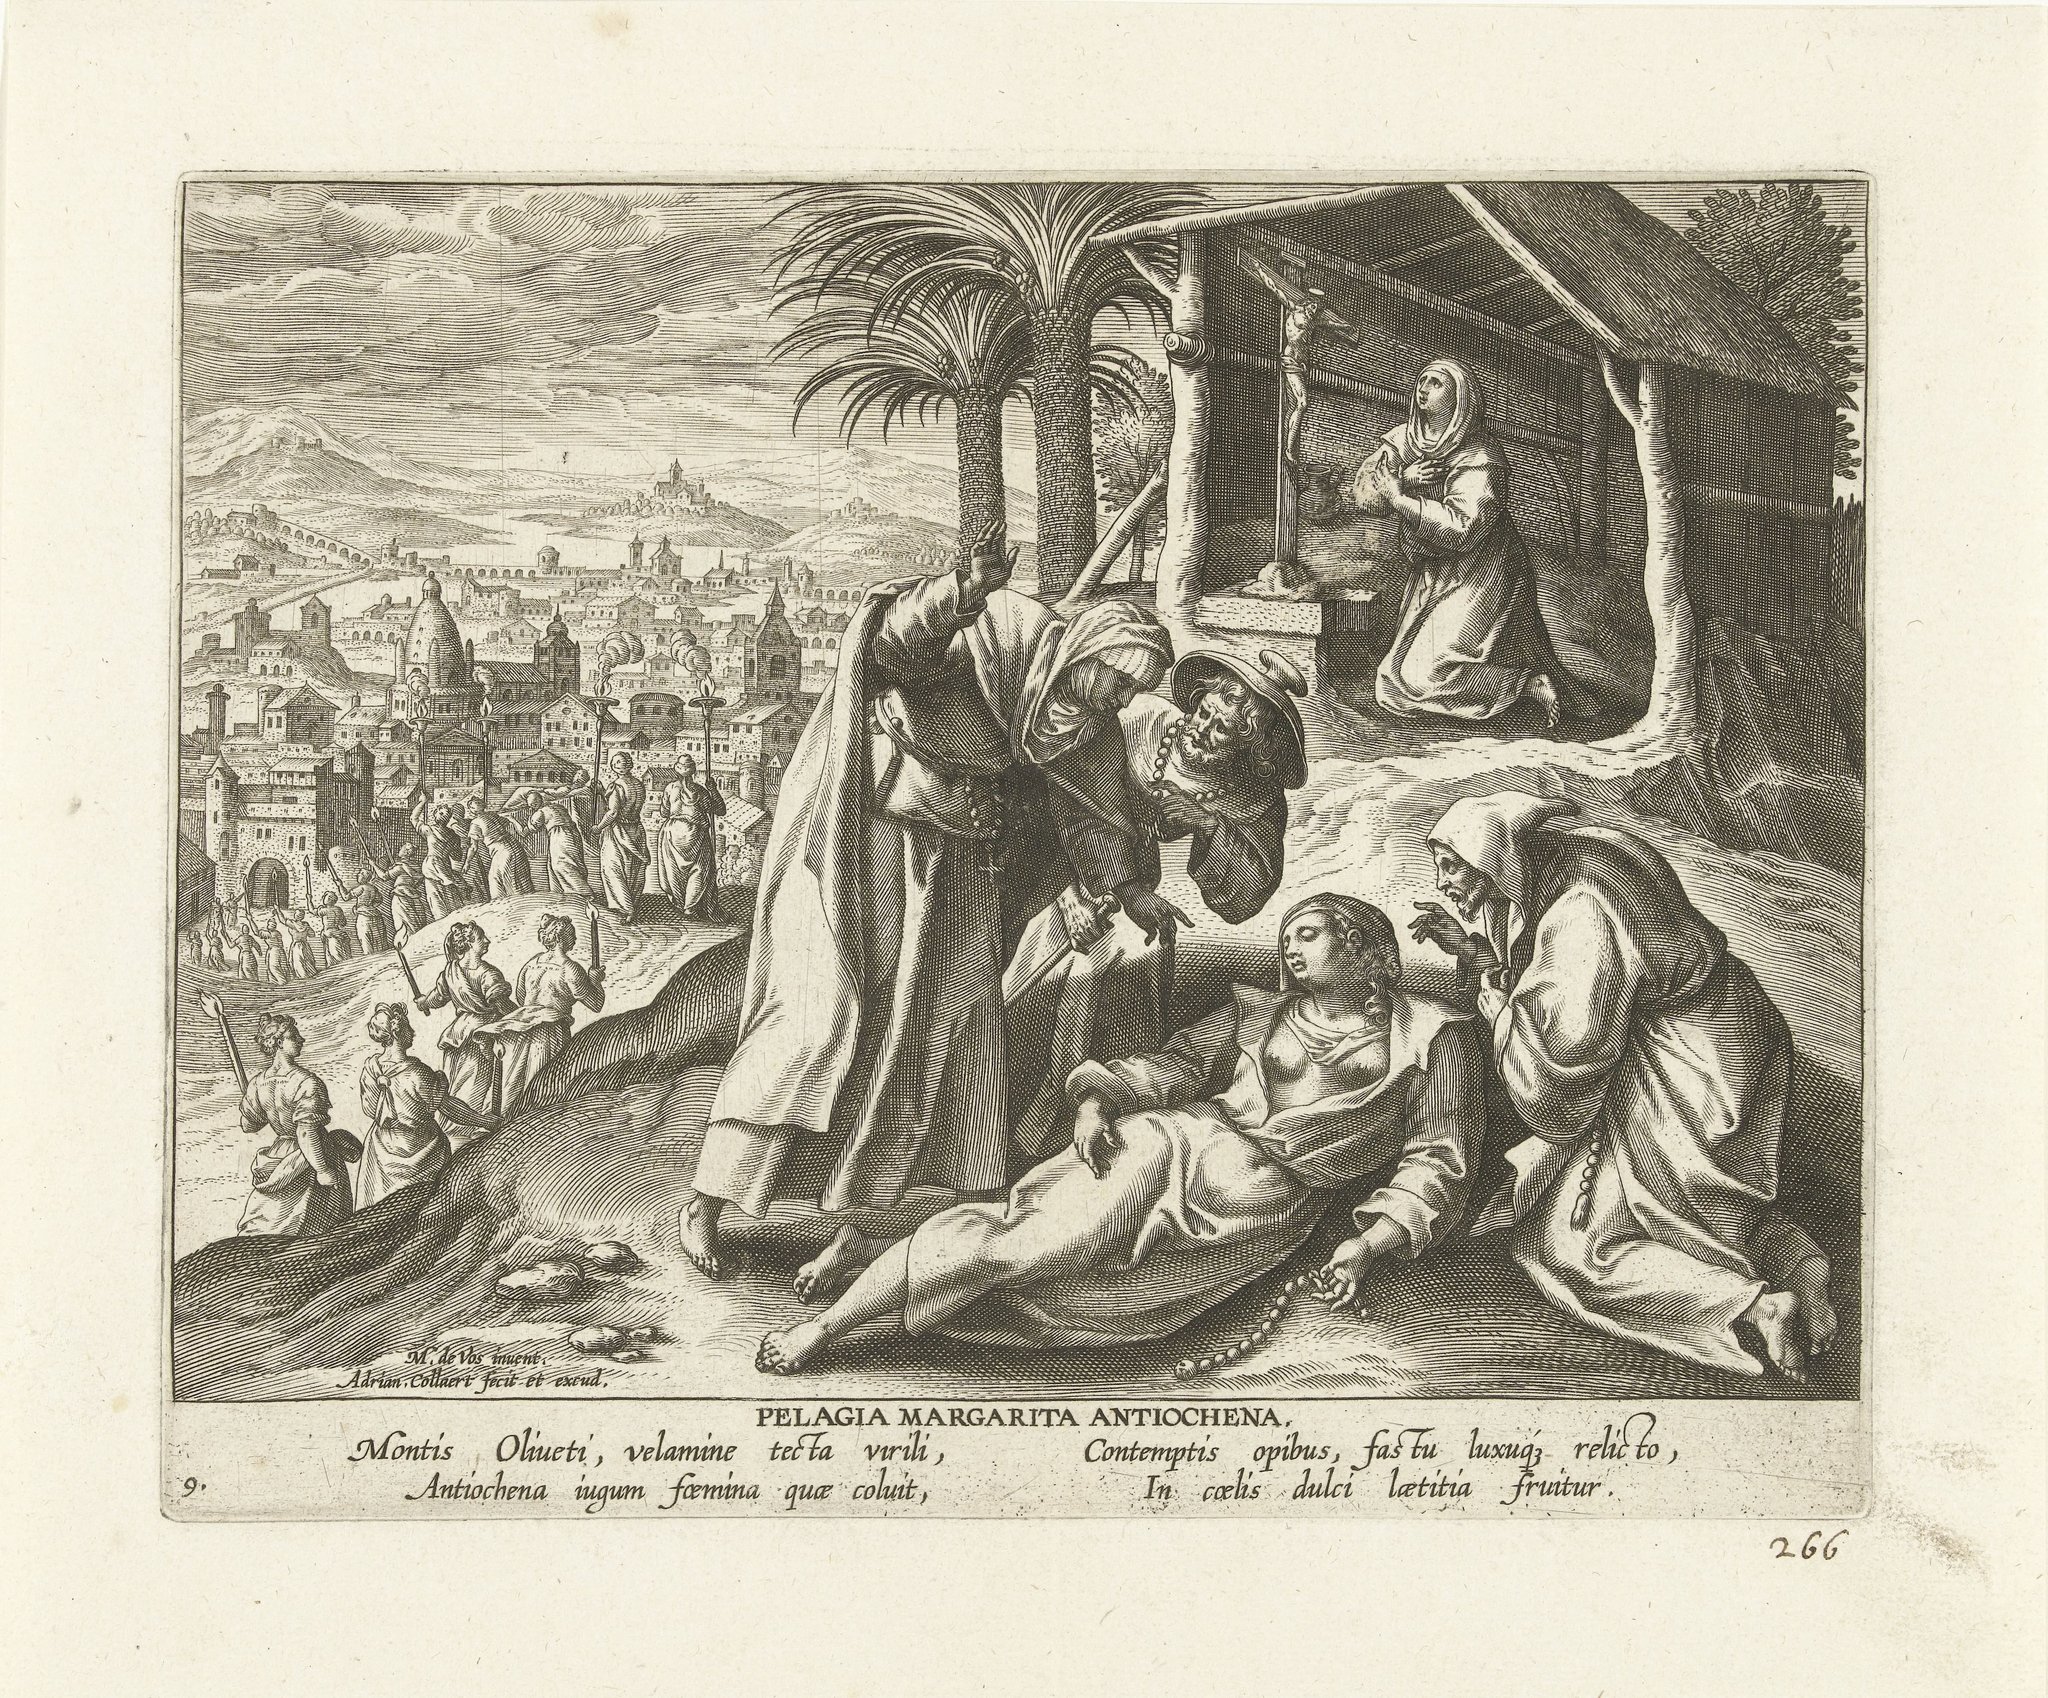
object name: print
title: Pelagia Margarita Antiochena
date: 1570-1618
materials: paper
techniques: engraving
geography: antwerp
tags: anchorite, hermit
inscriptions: number: ‘266’, collector's mark: Lugt 2228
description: Op de Olijfberg bidt Pelagia Margareta van Antiochië al knielend voor een kruisbeeld. Ze draagt mannenkleding. Op de voorgrond vinden voorbijgangers haar lichaam na haar dood. Ze ontbloten haar borst en ontdekken dat ze een vrouw is. Op de achtergrond de doodsprocessie van Pelagia Margareta. De prent heeft een Latijns onderschrift en maakt deel uit van een serie uit vierentwintig prenten met als onderwerp vrouwelijke kluizenaars.